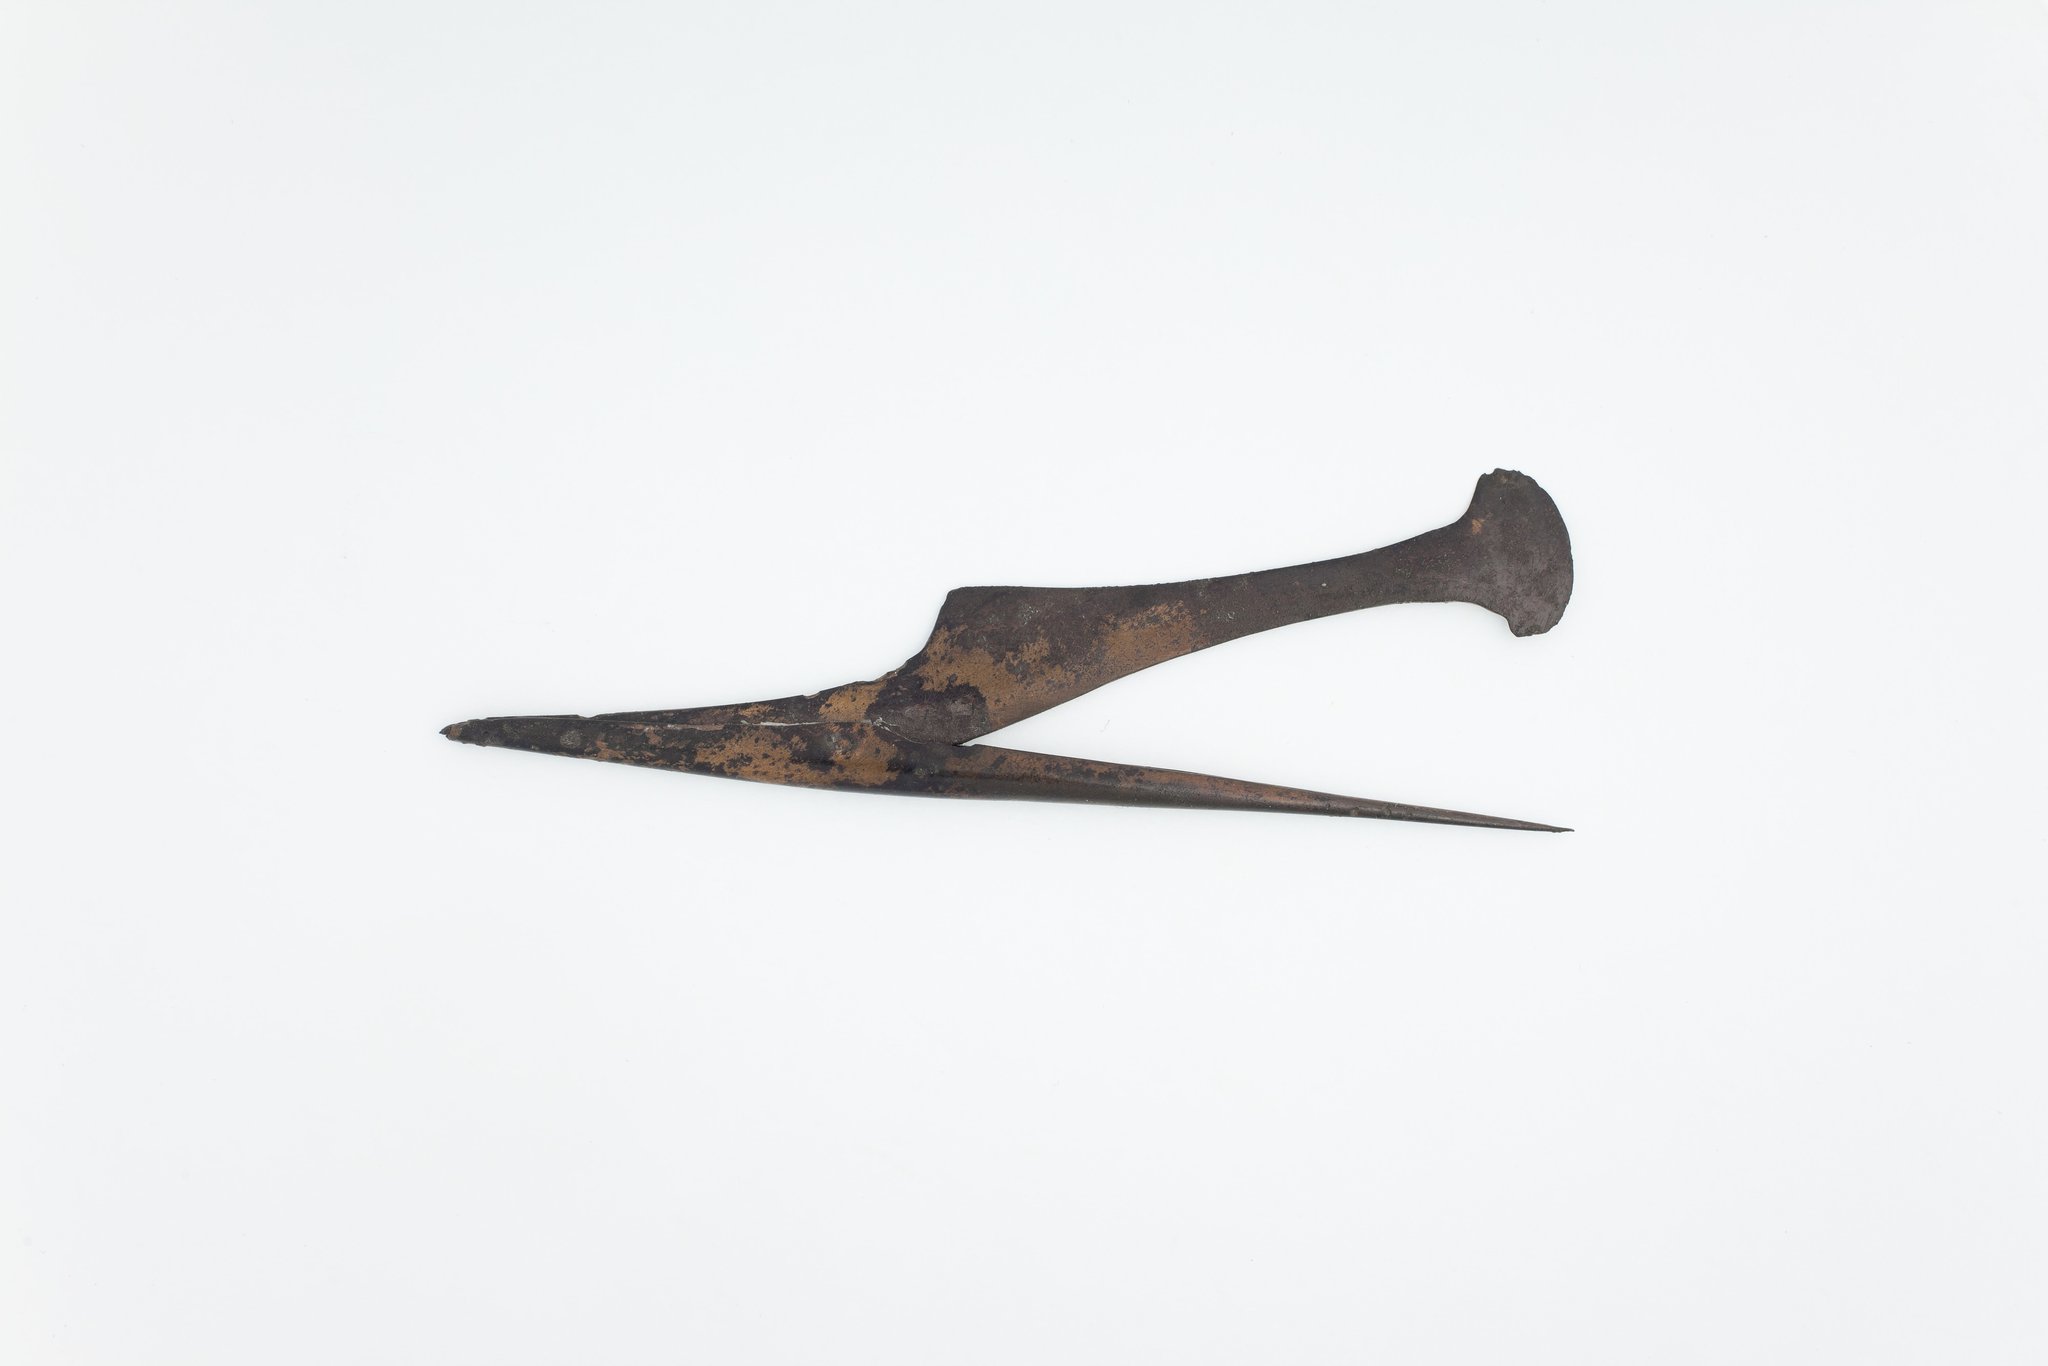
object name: tweezer razor, razor, tweezer, hair curler, knife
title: Tweezer-razor from the Burial of Amenemhat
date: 1504-1447 BCE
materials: bronze, copper alloy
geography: egypt